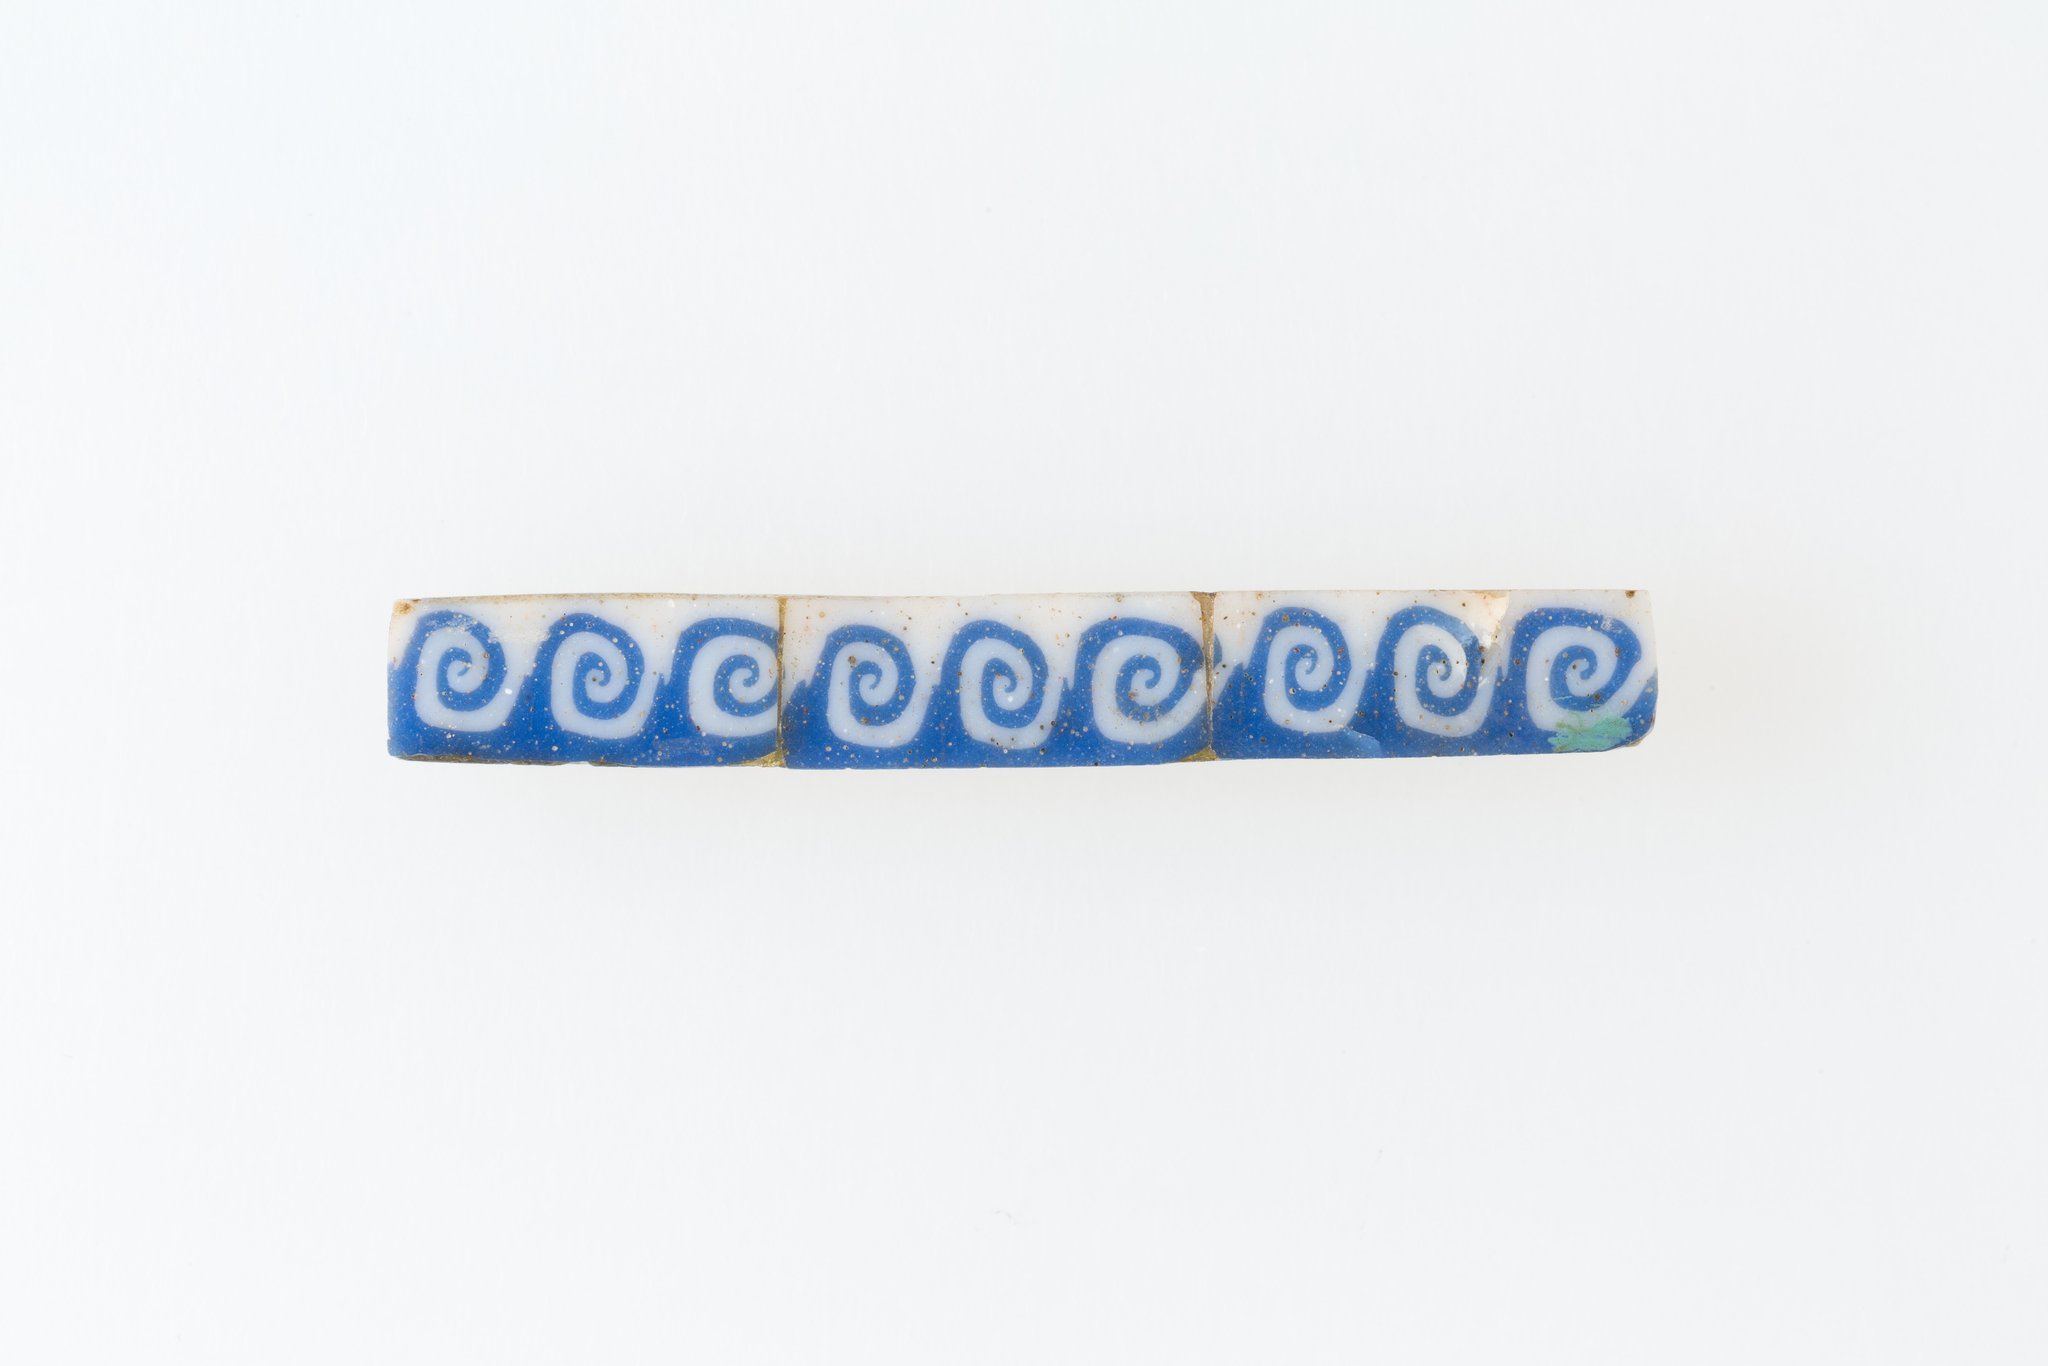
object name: inlay, spiral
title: Inlay, running spirals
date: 200 BCE-100 CE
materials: glass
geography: egypt